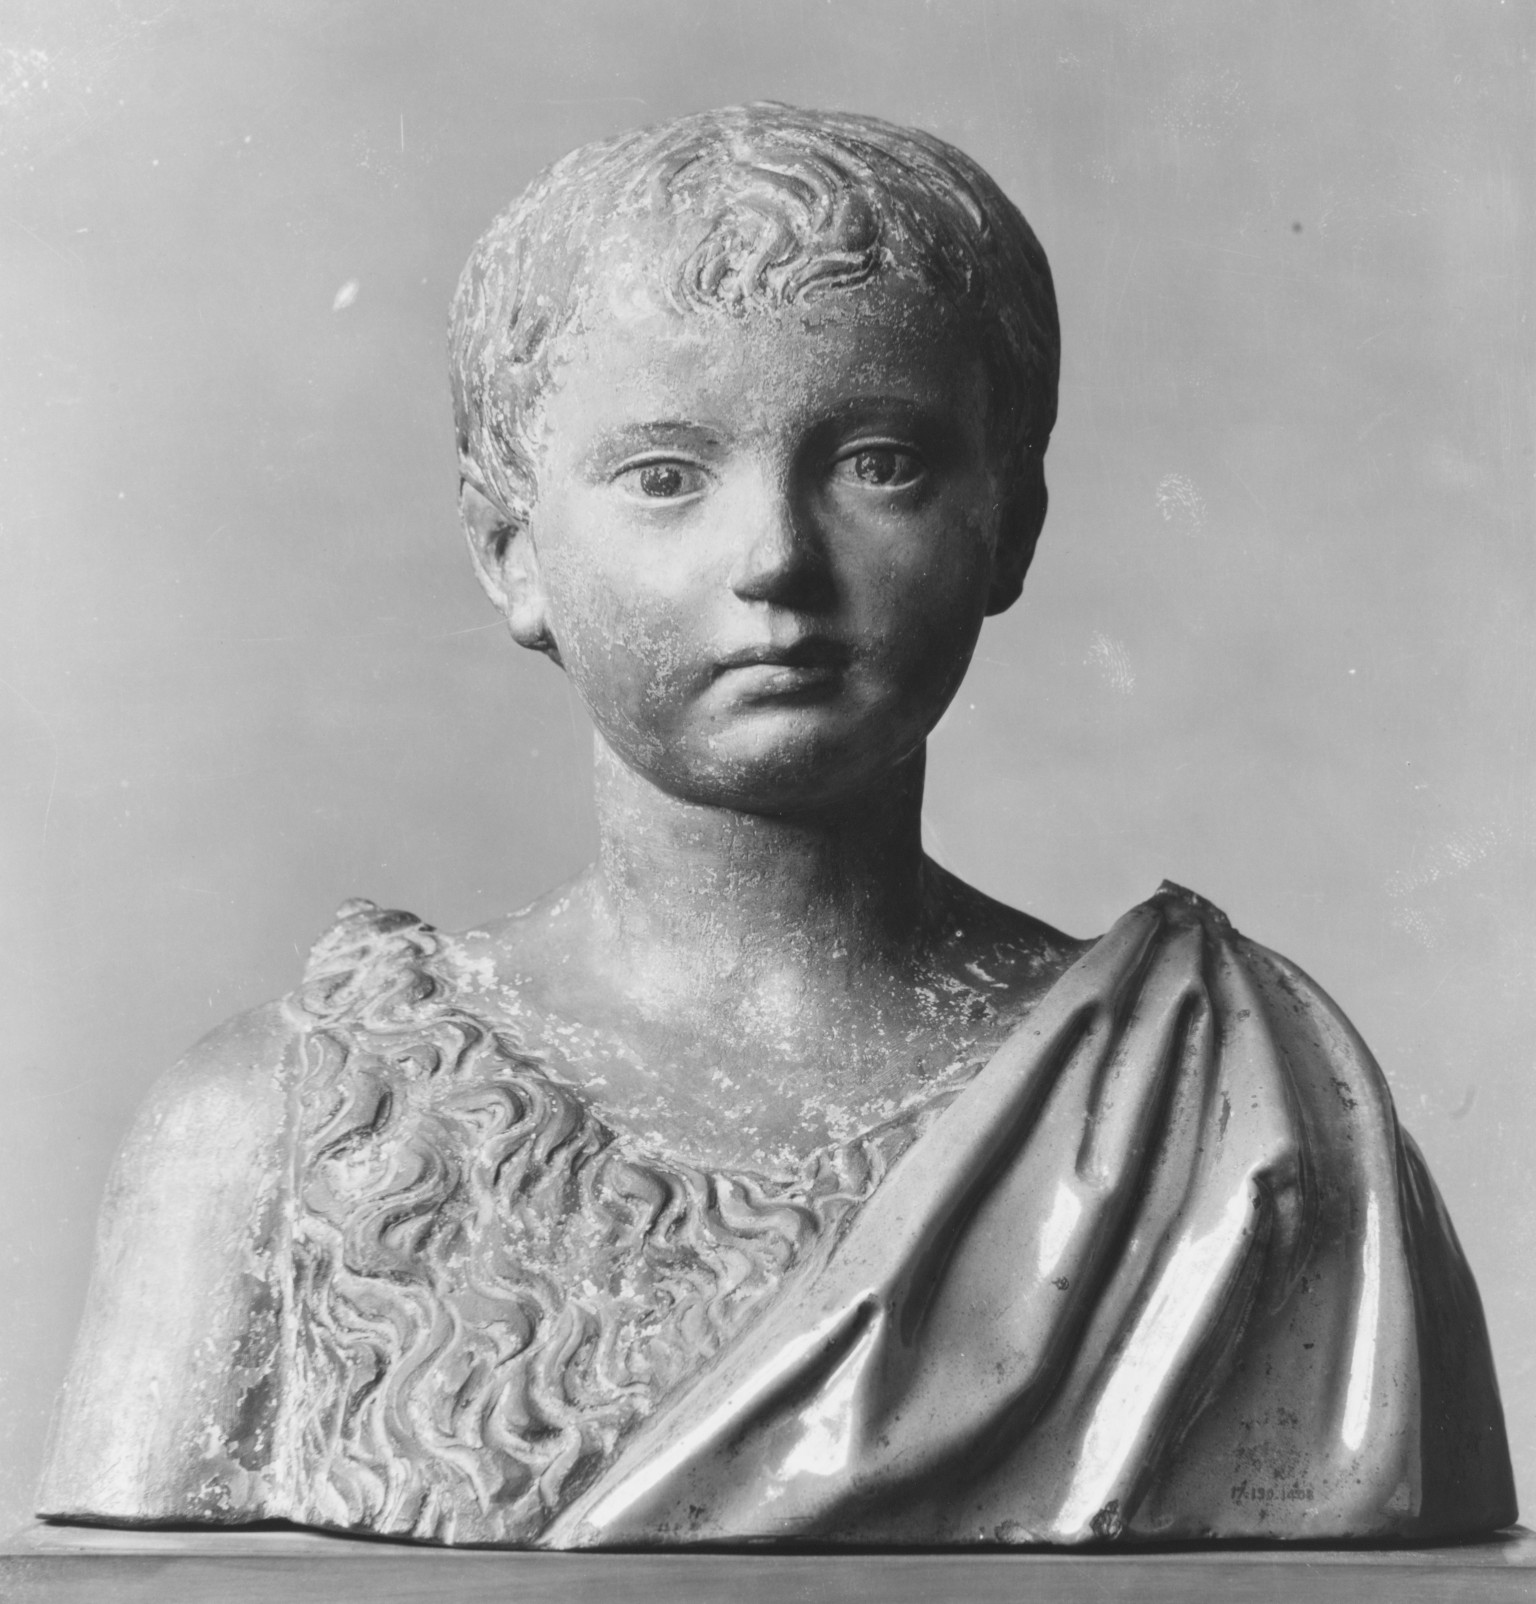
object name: bust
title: Boy Saint John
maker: giovanni della robbia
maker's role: artist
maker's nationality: italian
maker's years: 1469-1530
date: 1401-1600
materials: terracotta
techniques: enamel, painting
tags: boys,saints